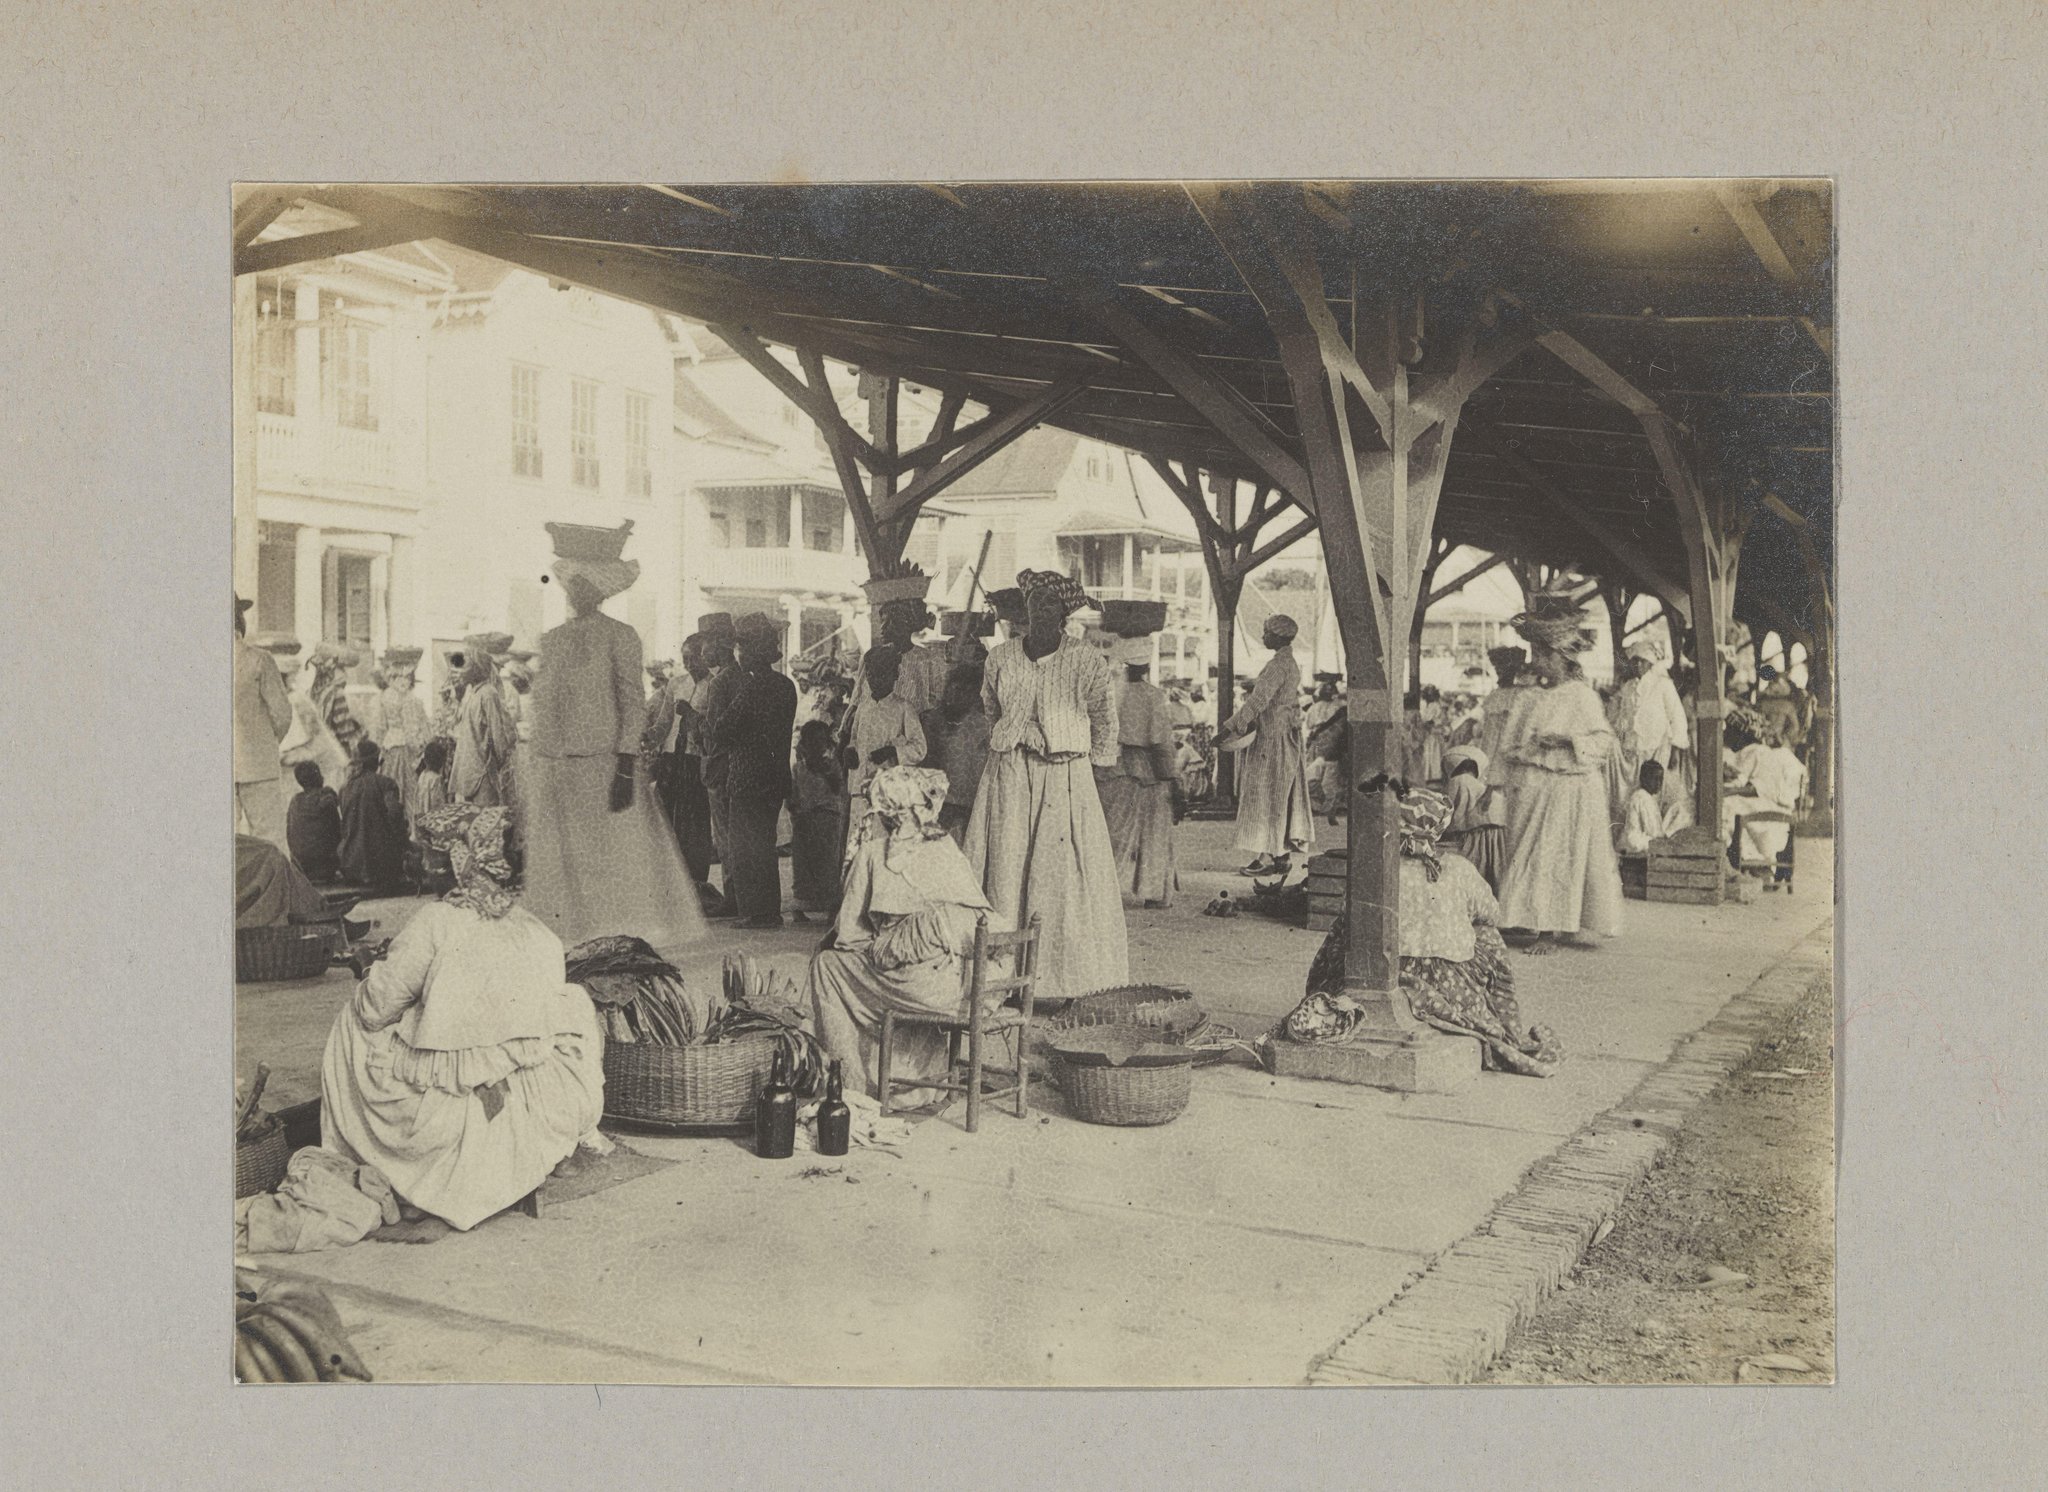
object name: photograph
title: Overdekte markt, Heiligenweg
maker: hendrik doijer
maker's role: engineer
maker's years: 1863-1925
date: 1903-1910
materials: photographic support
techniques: gelatin silver print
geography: suriname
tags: suriname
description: Gezicht op de overdekte markt aan de Heiligenweg te Paramaribo. Marktverkoopsters zitten tussen hun waren op de grond. Onderdeel van het fotoalbum Souvenir de Voyage (deel 5), over het leven van de familie Doijer in en rond de plantage Ma Retraite in Suriname in de jaren 1903-1910.